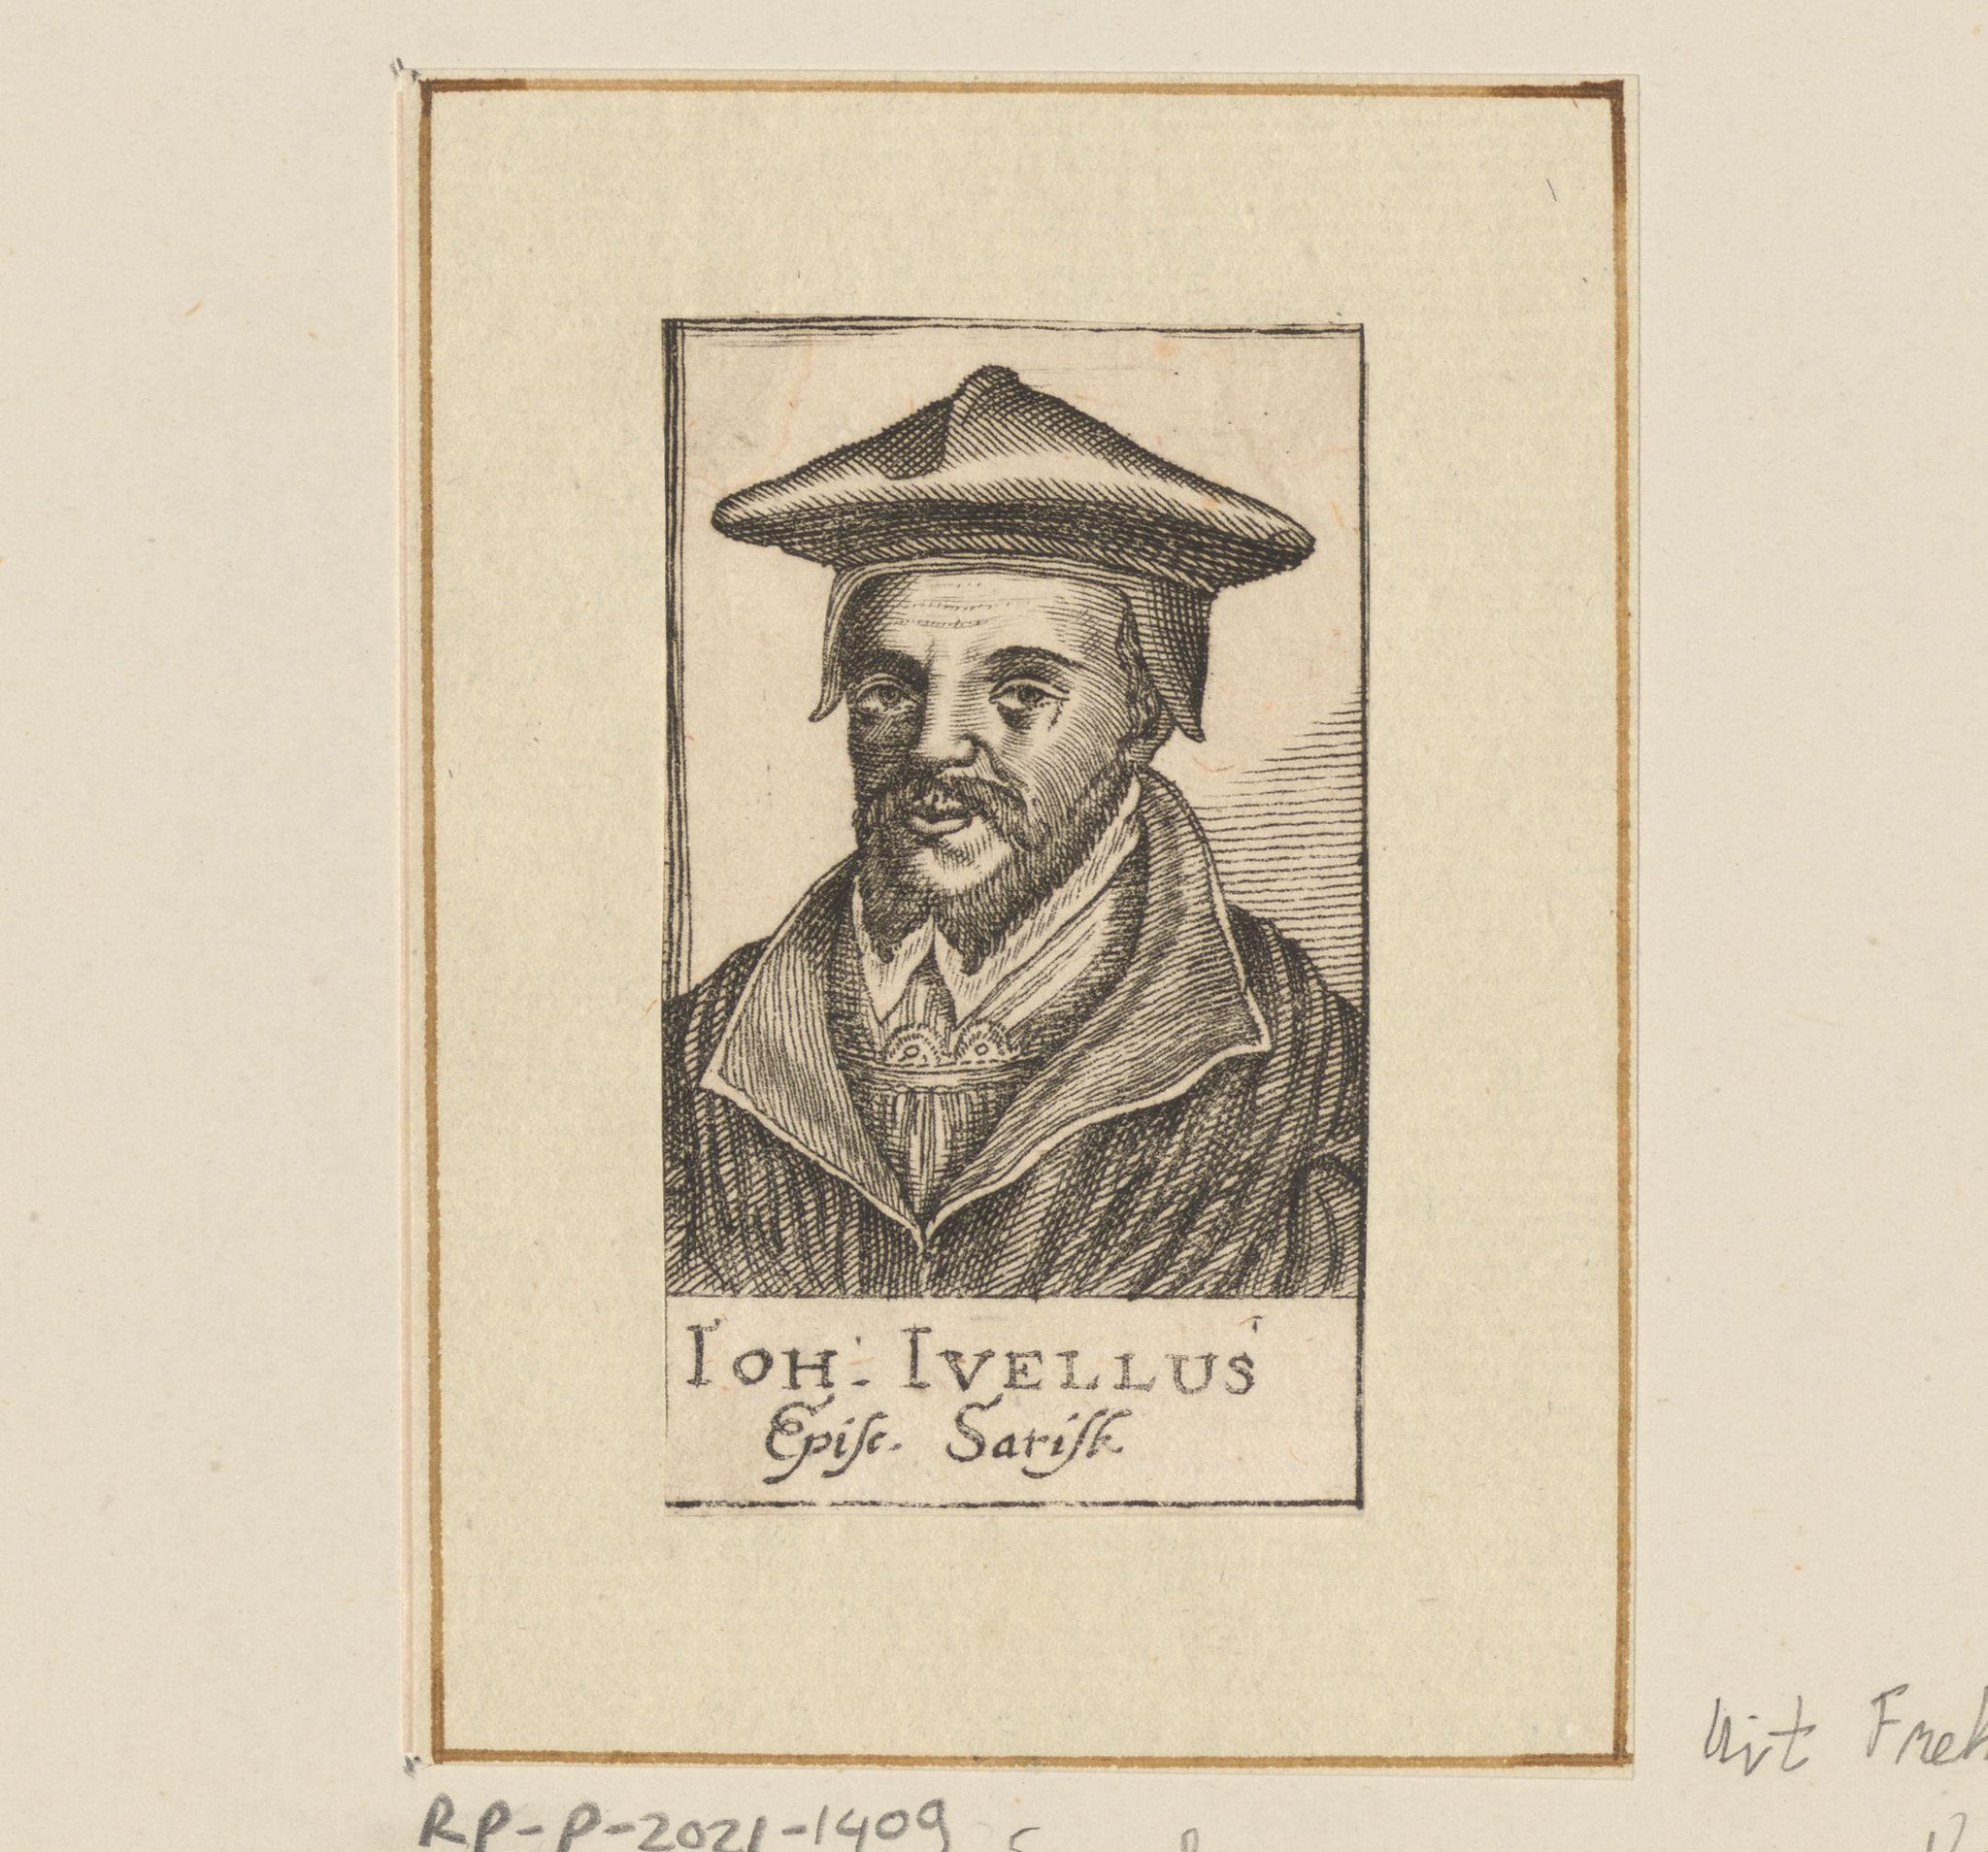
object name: print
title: Portret van John Jewel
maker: Anonymous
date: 1688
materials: paper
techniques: engraving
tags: archbishop, bishop, etc. (roman catholic), historical persons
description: Prent maakt deel uit van een grotere prent die later is verknipt. Prent waarschijnlijk uit: Freher, Paul. Theatrum virorum eruditione clarorum. Neurenberg: Johann Hoffmann, 1688.